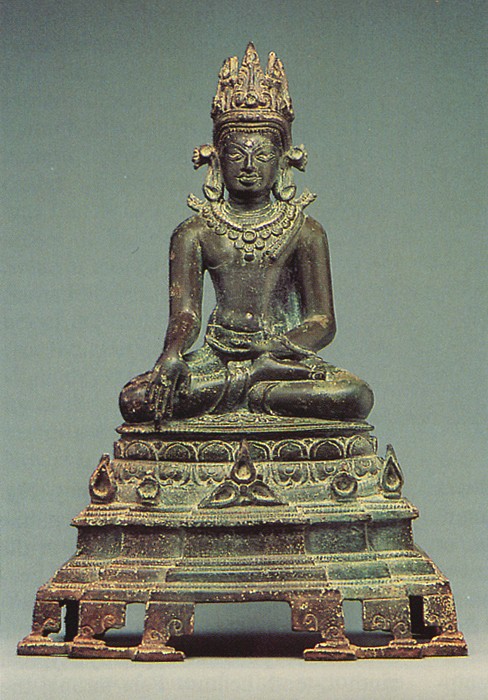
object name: figure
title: Seated Crowned and Jeweled Buddha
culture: indian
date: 967-1000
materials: bronze, silver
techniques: inlay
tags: buddhism,buddha